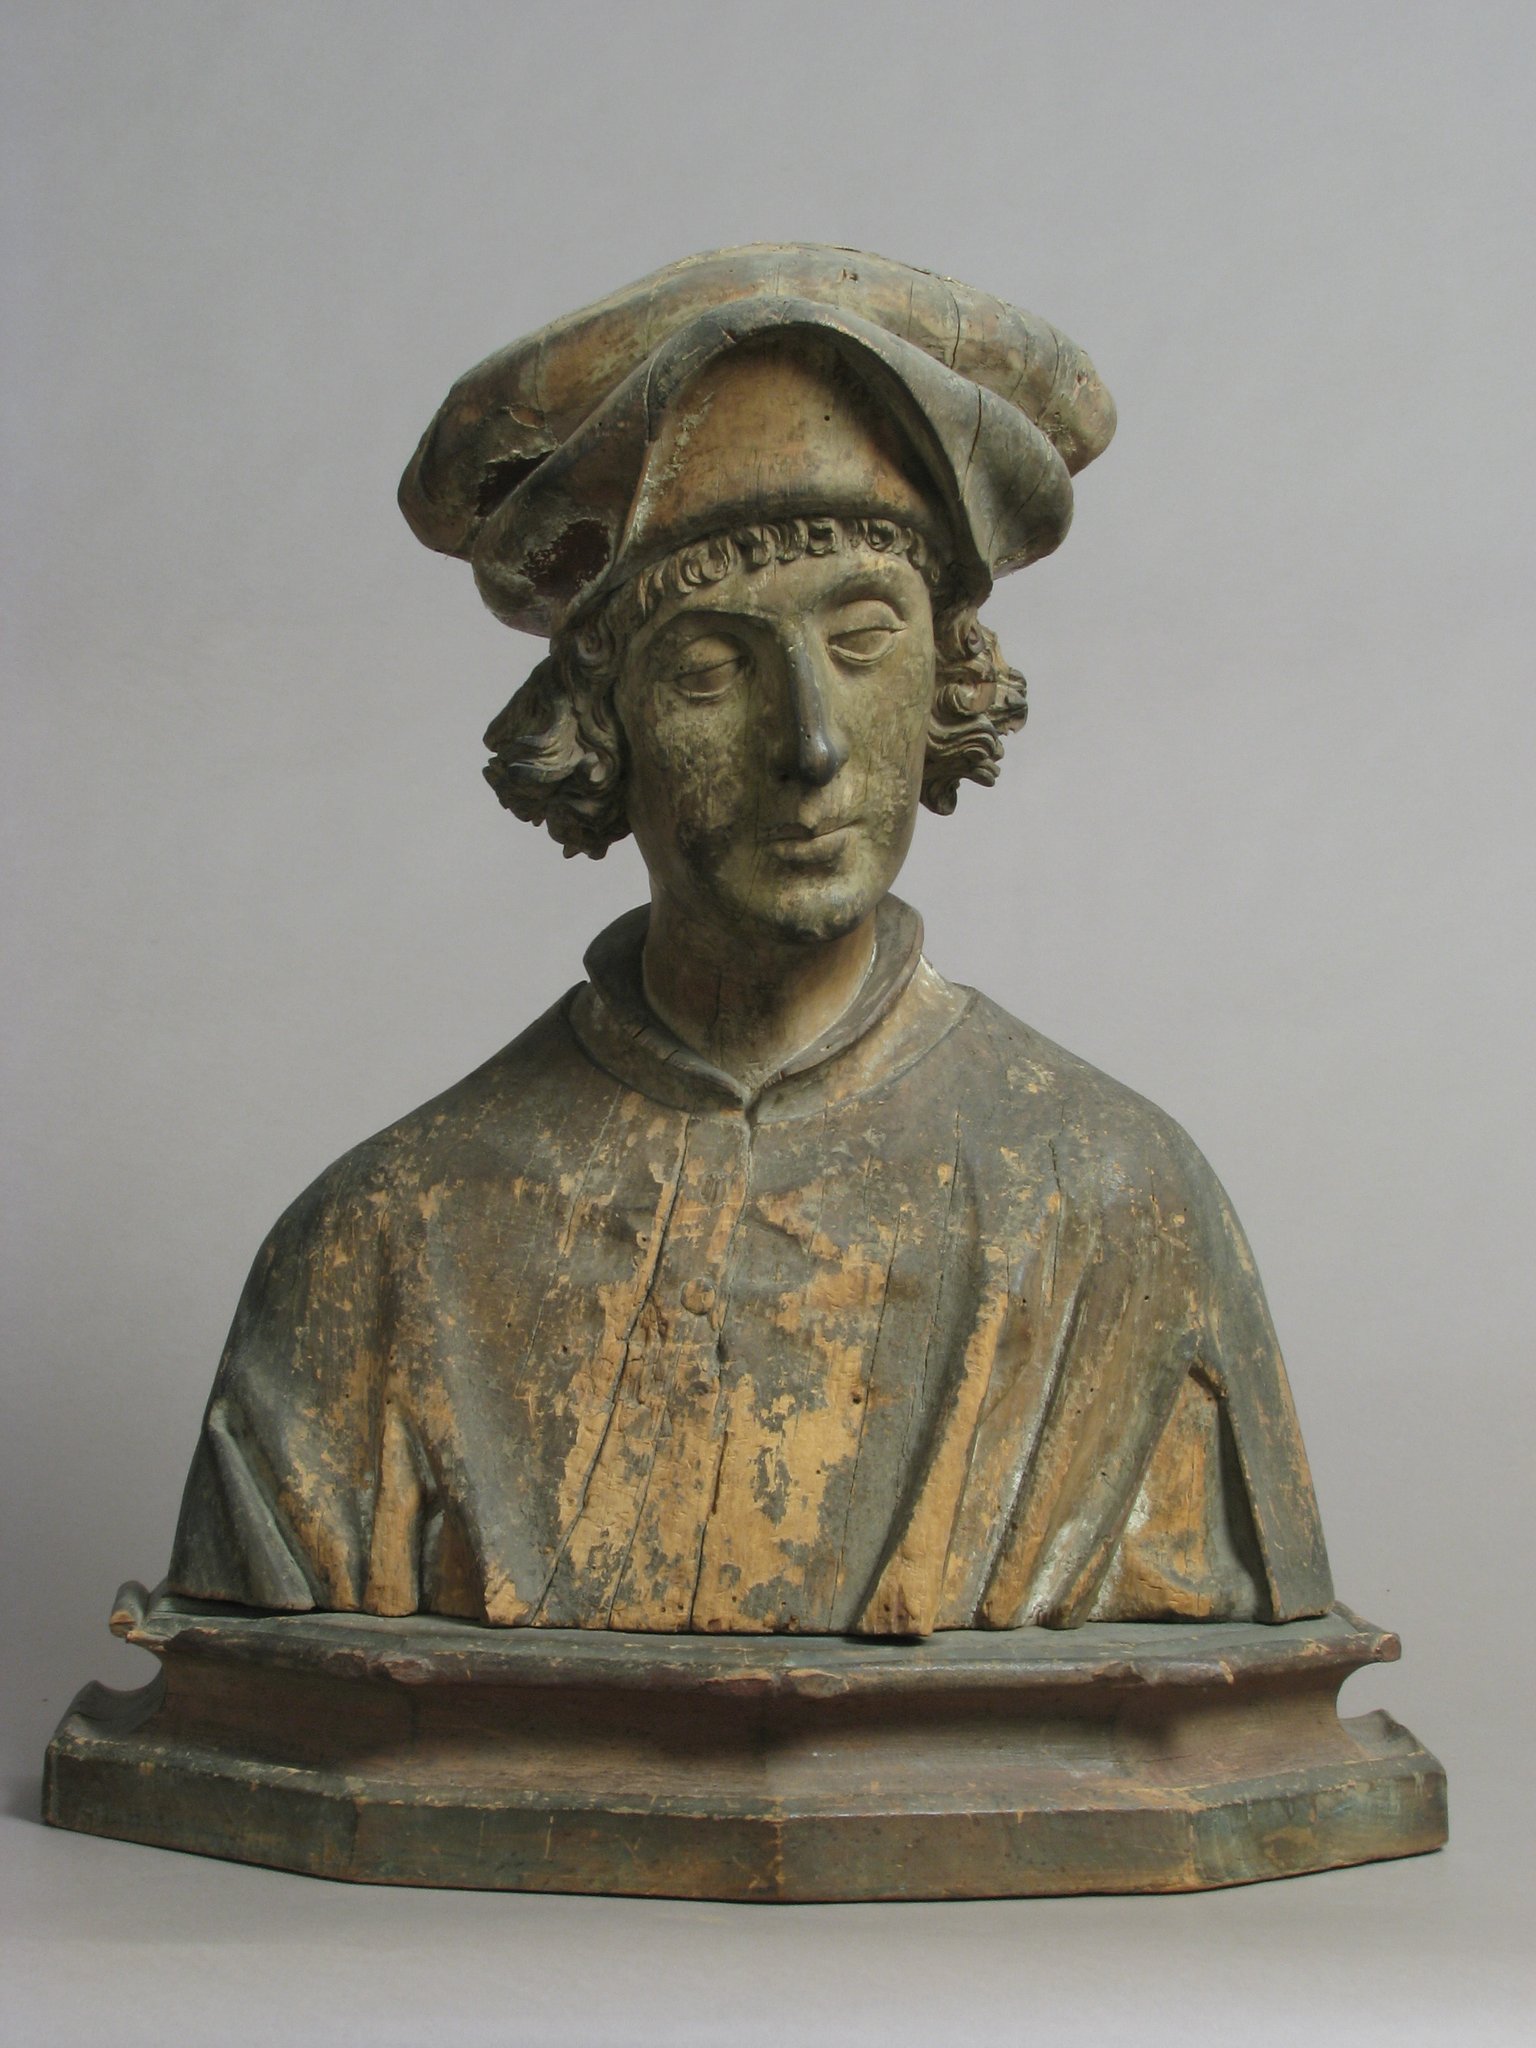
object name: bust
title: Portrait Bust of a Young Man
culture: german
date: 1501-1600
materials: wood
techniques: polychromy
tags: portraits